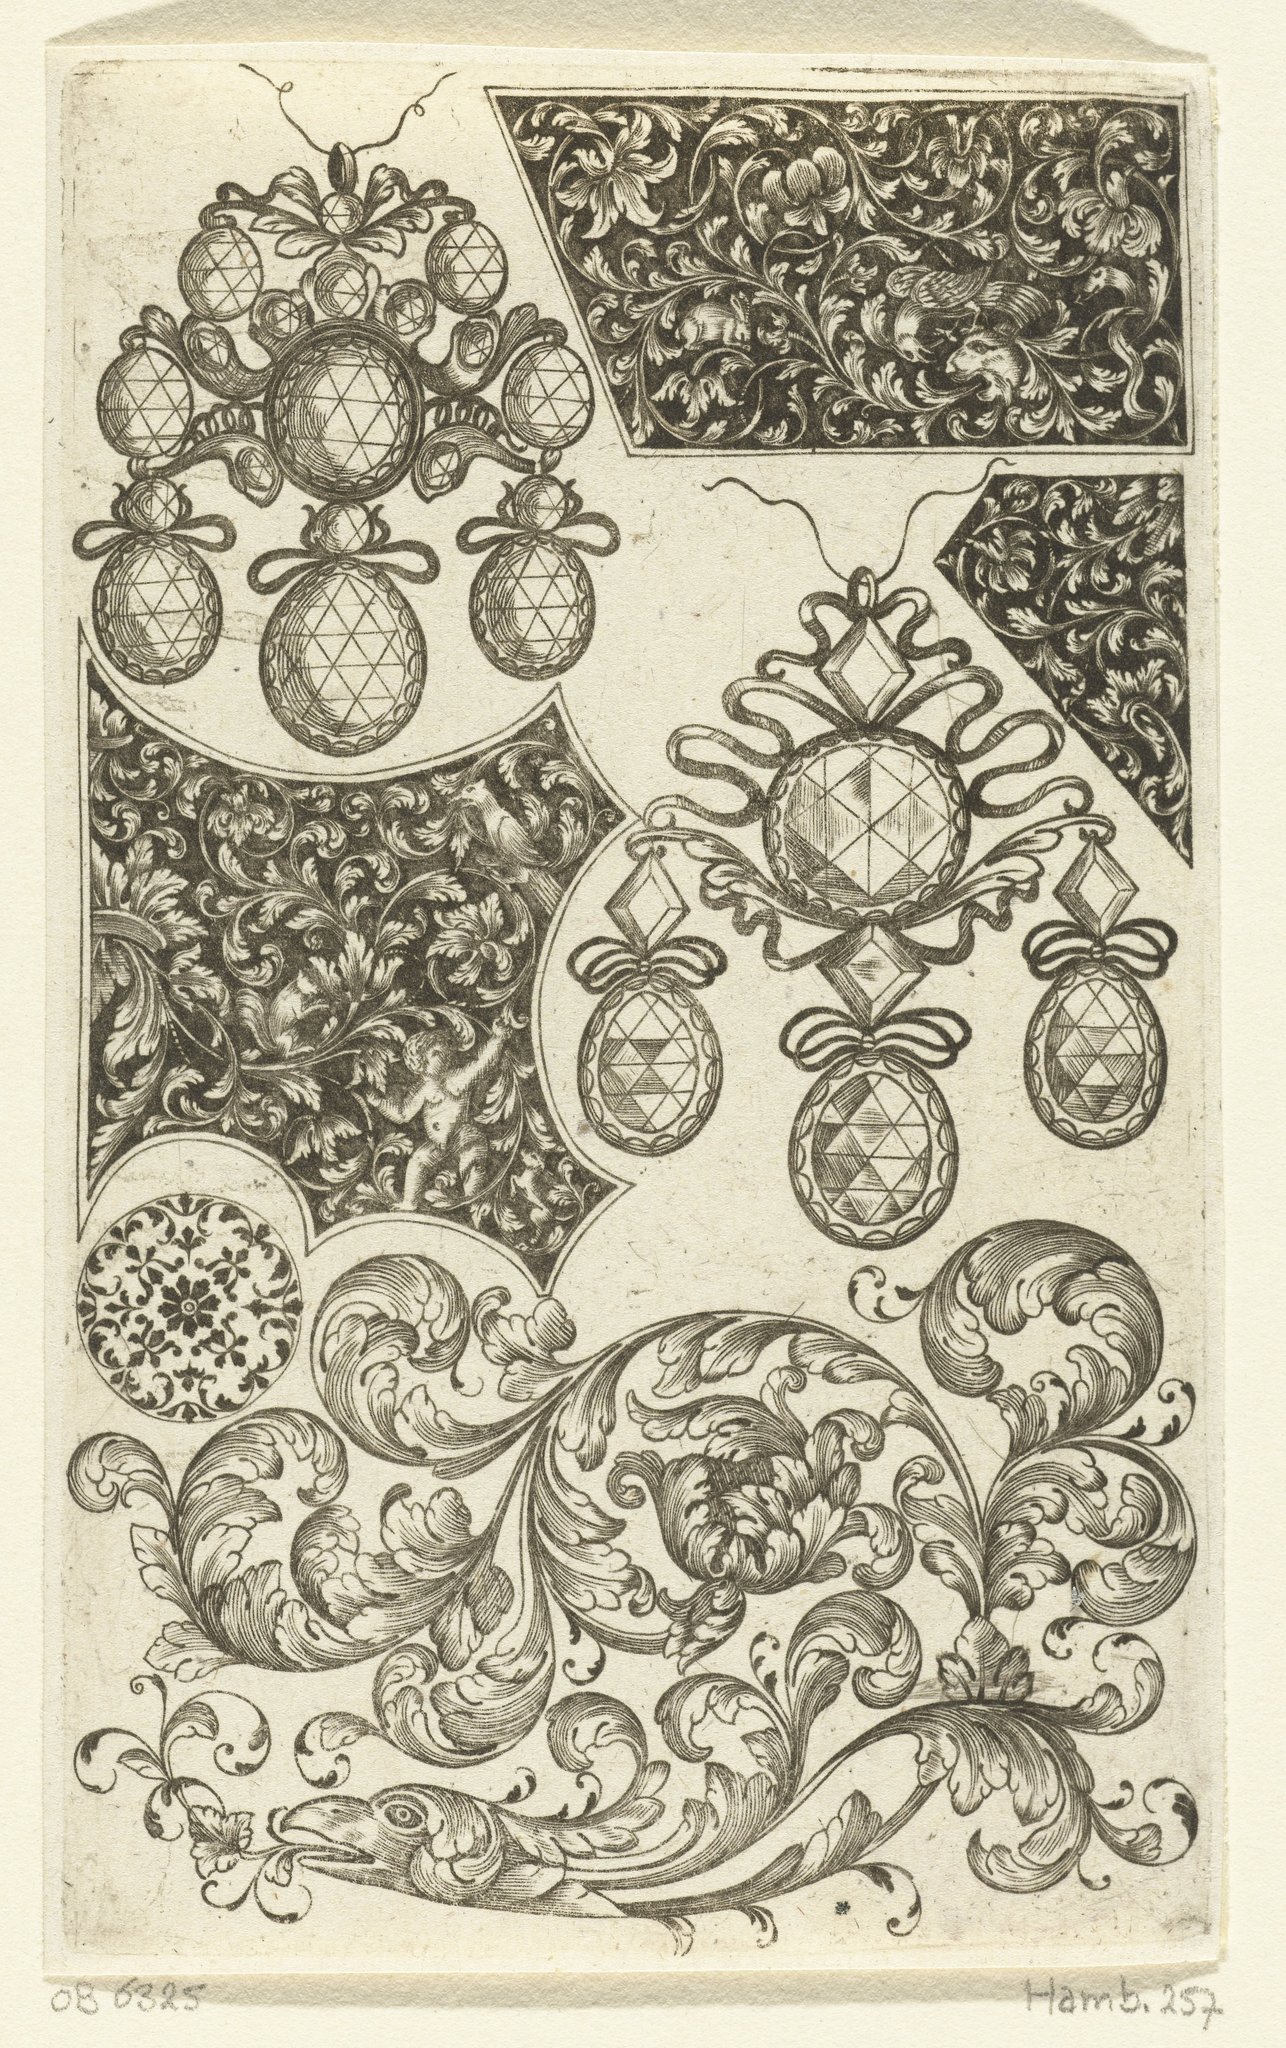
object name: print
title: Zeven ornamenten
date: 1600-1699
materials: paper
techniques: engraving, etching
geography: netherlands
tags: hare-hunting, rabbit-hunting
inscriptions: collector's mark: Lugt 240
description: Drie rankornamenten op een zwarte achtergrond, twee hangers en een rankornament op een witte achtergrond. Uit serie bestaande uit een titelblad en 9 bladen.